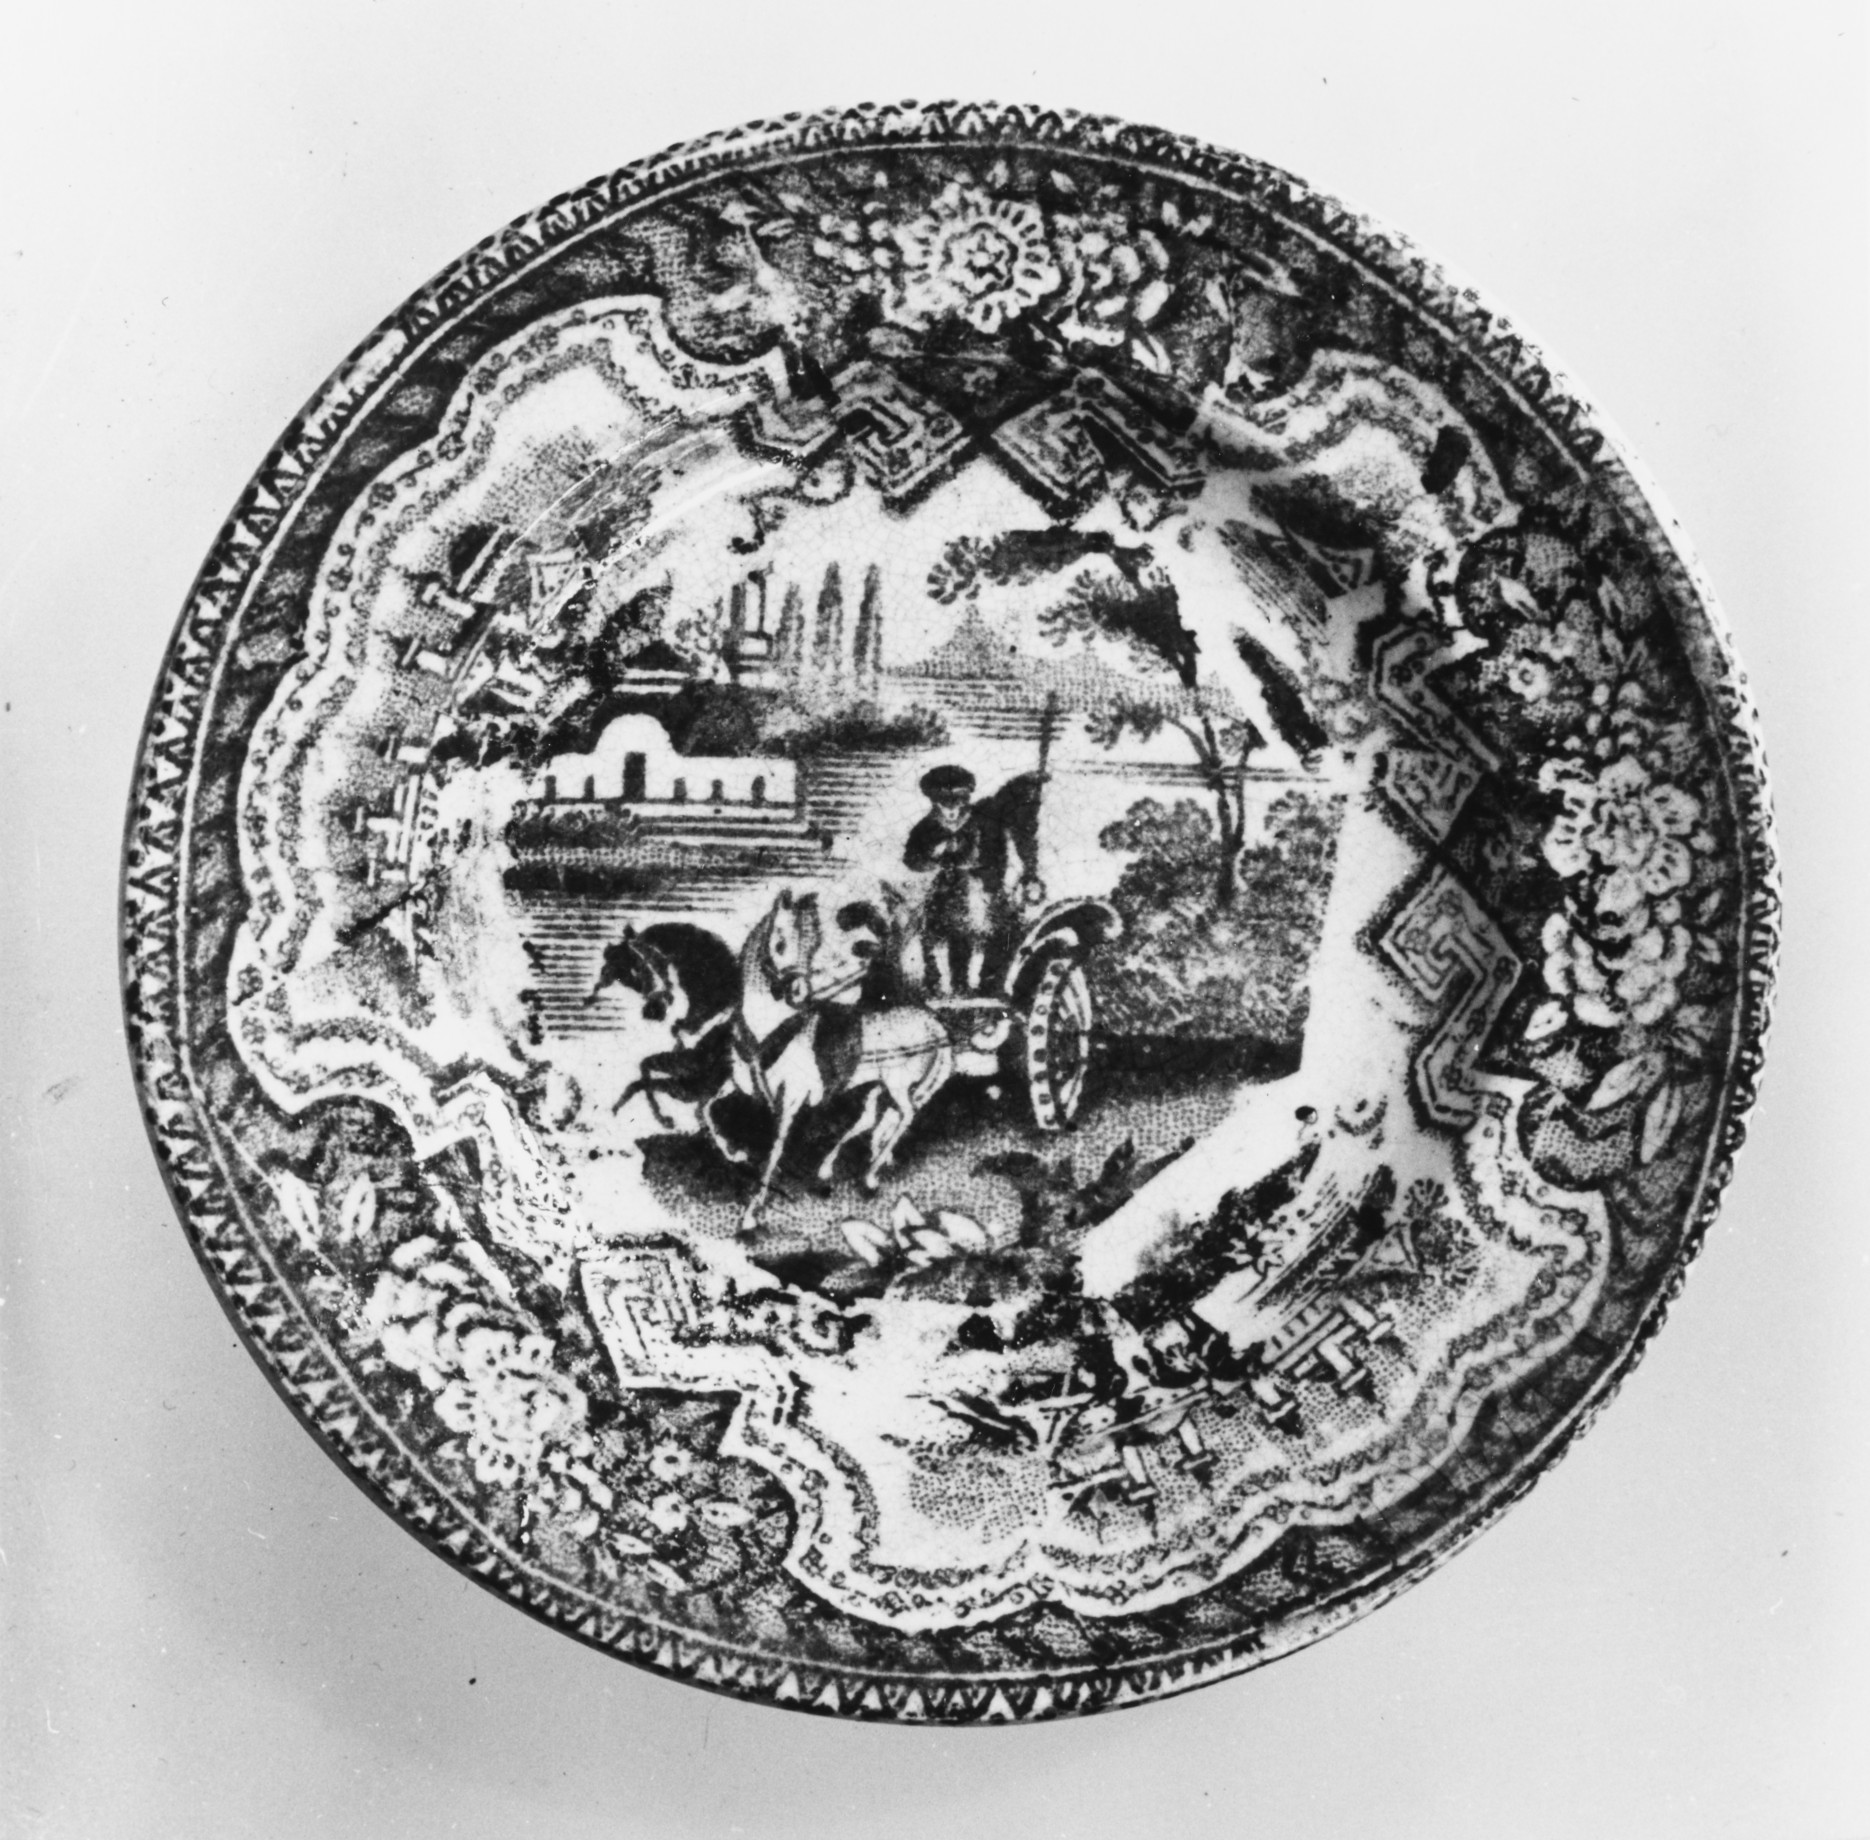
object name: cup plate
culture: british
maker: william adams & sons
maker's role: maker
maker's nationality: british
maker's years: 1814-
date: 1830-1864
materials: earthenware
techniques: transfer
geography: england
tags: men,horses,chariots